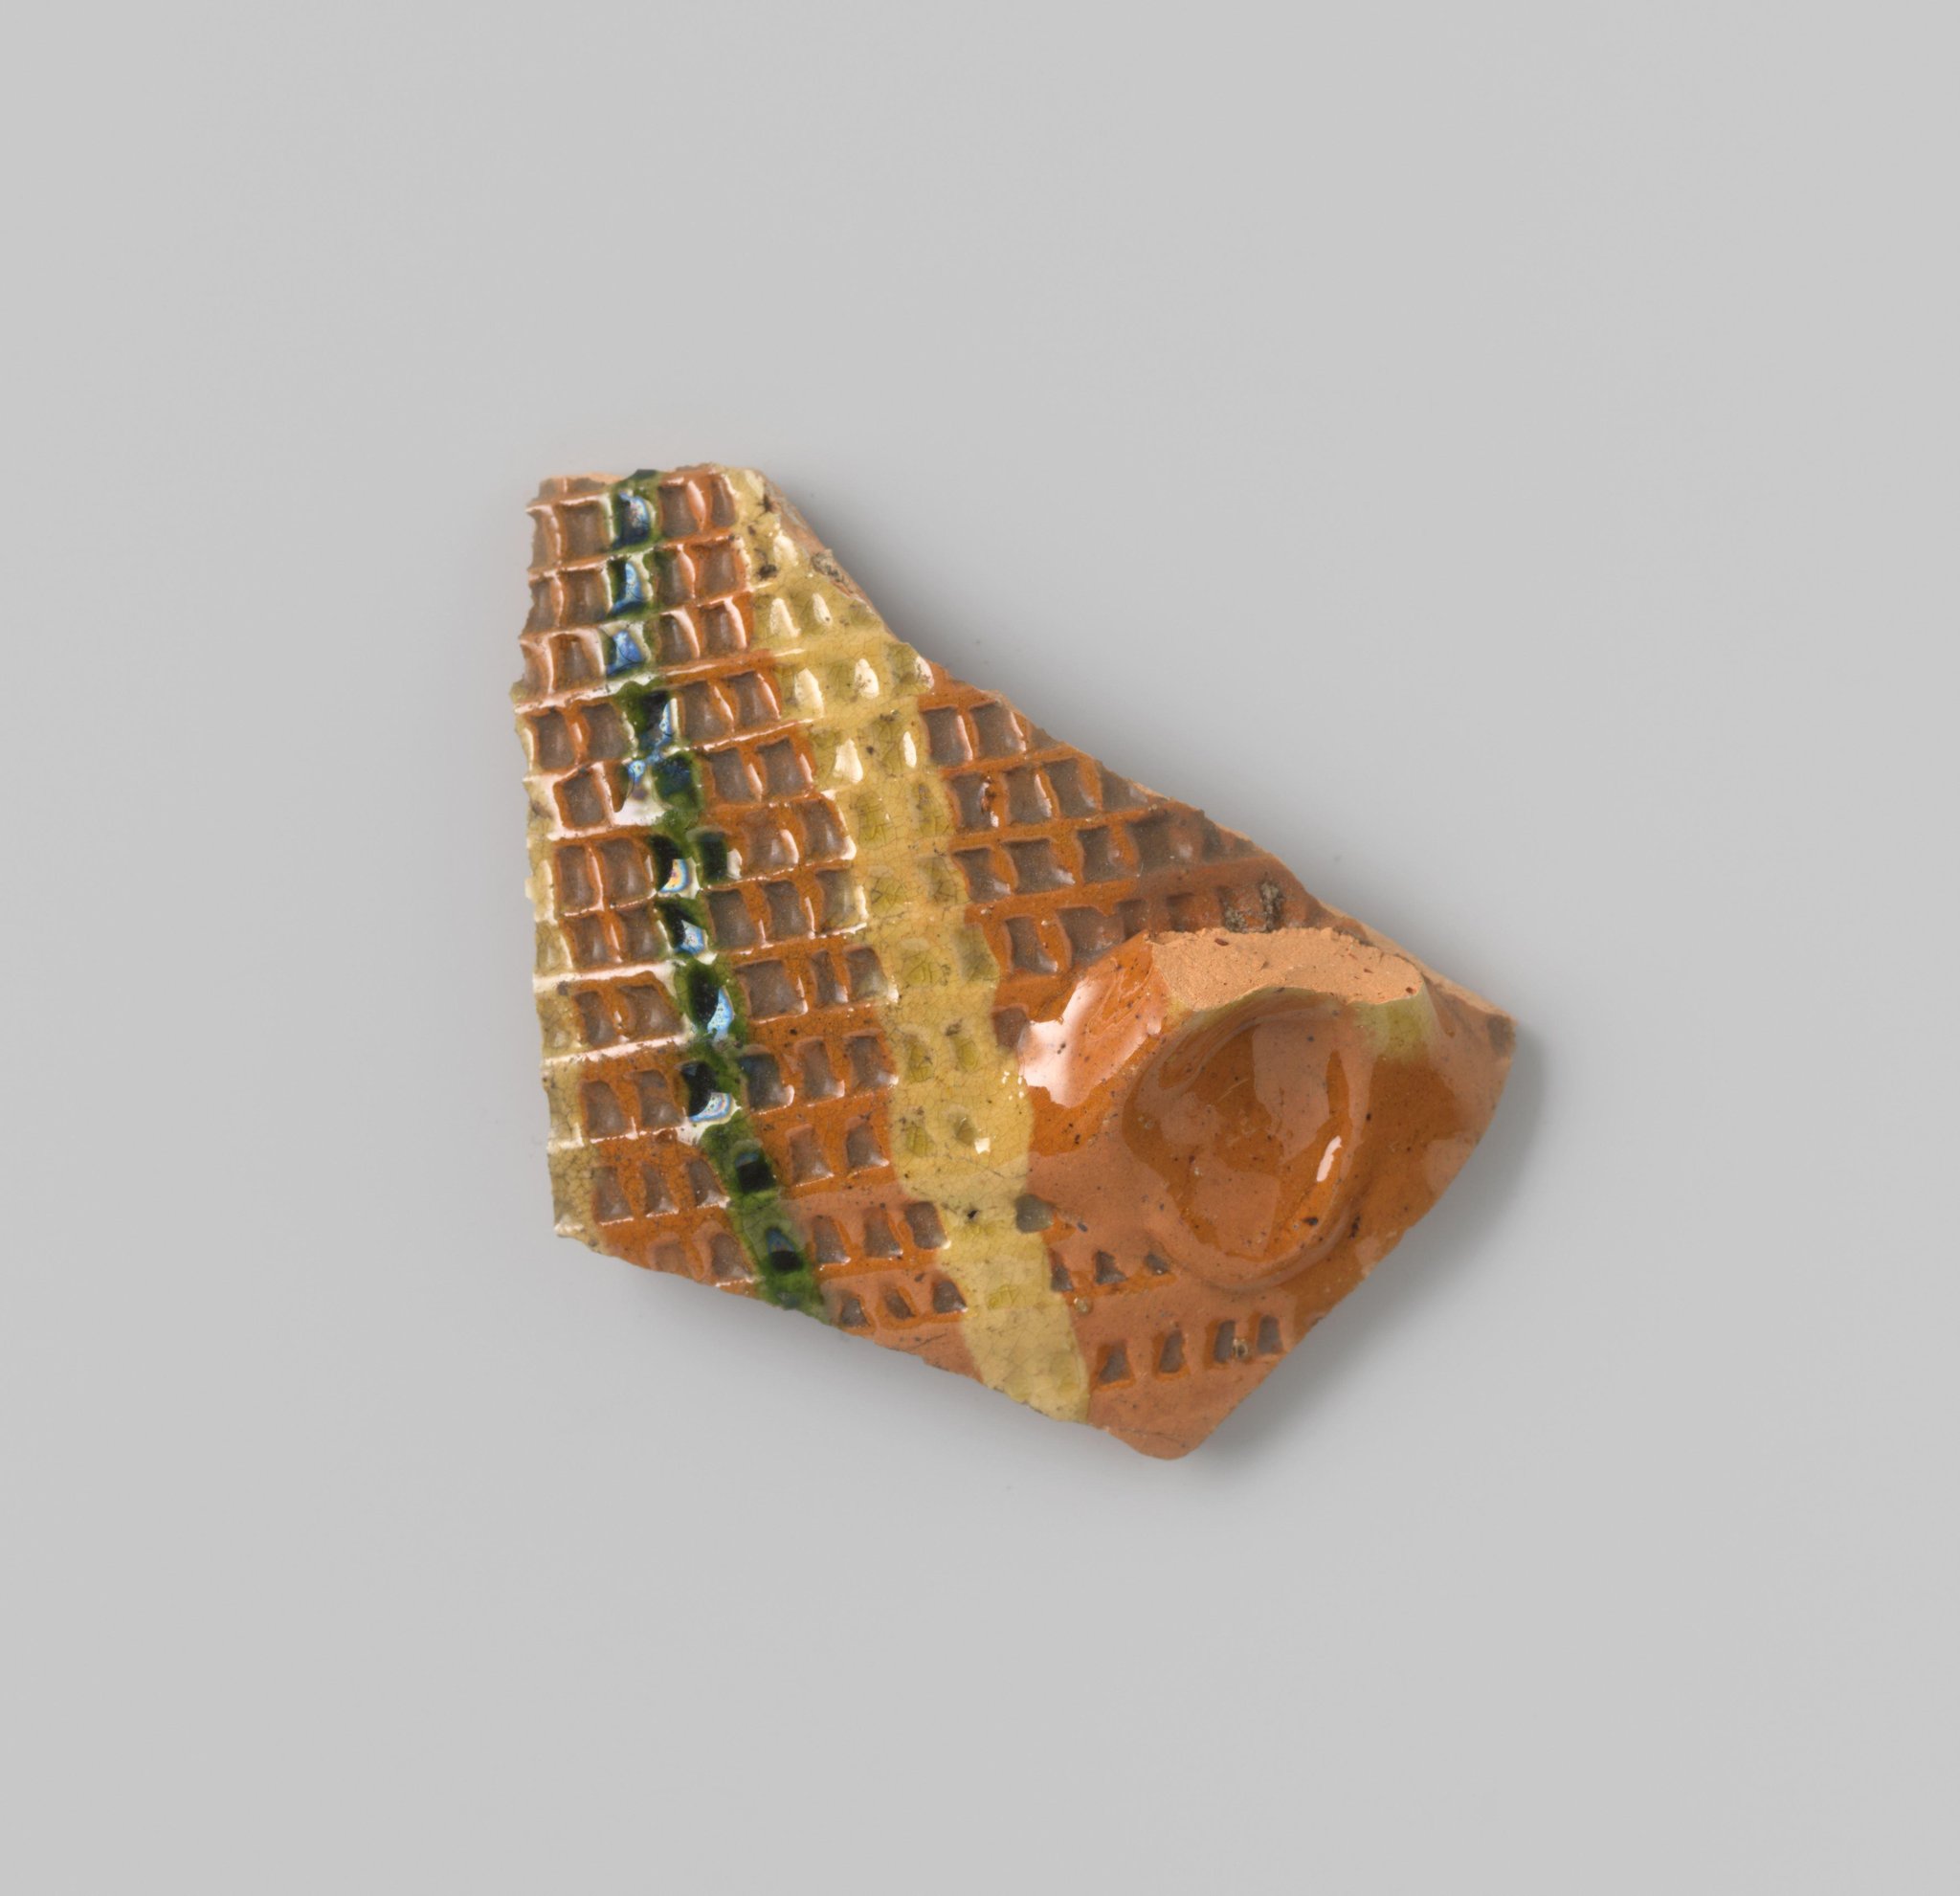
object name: fragment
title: Schotelscherf van roodbakkend aardewerk, voorzien van een ribbelstructuur en gele en groene streep glazuur aan de buitenzijde, en van kleurloos glazuur aan de binnen- en buitenzijde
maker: Anonymous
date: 1500-1699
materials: earthenware, glaze